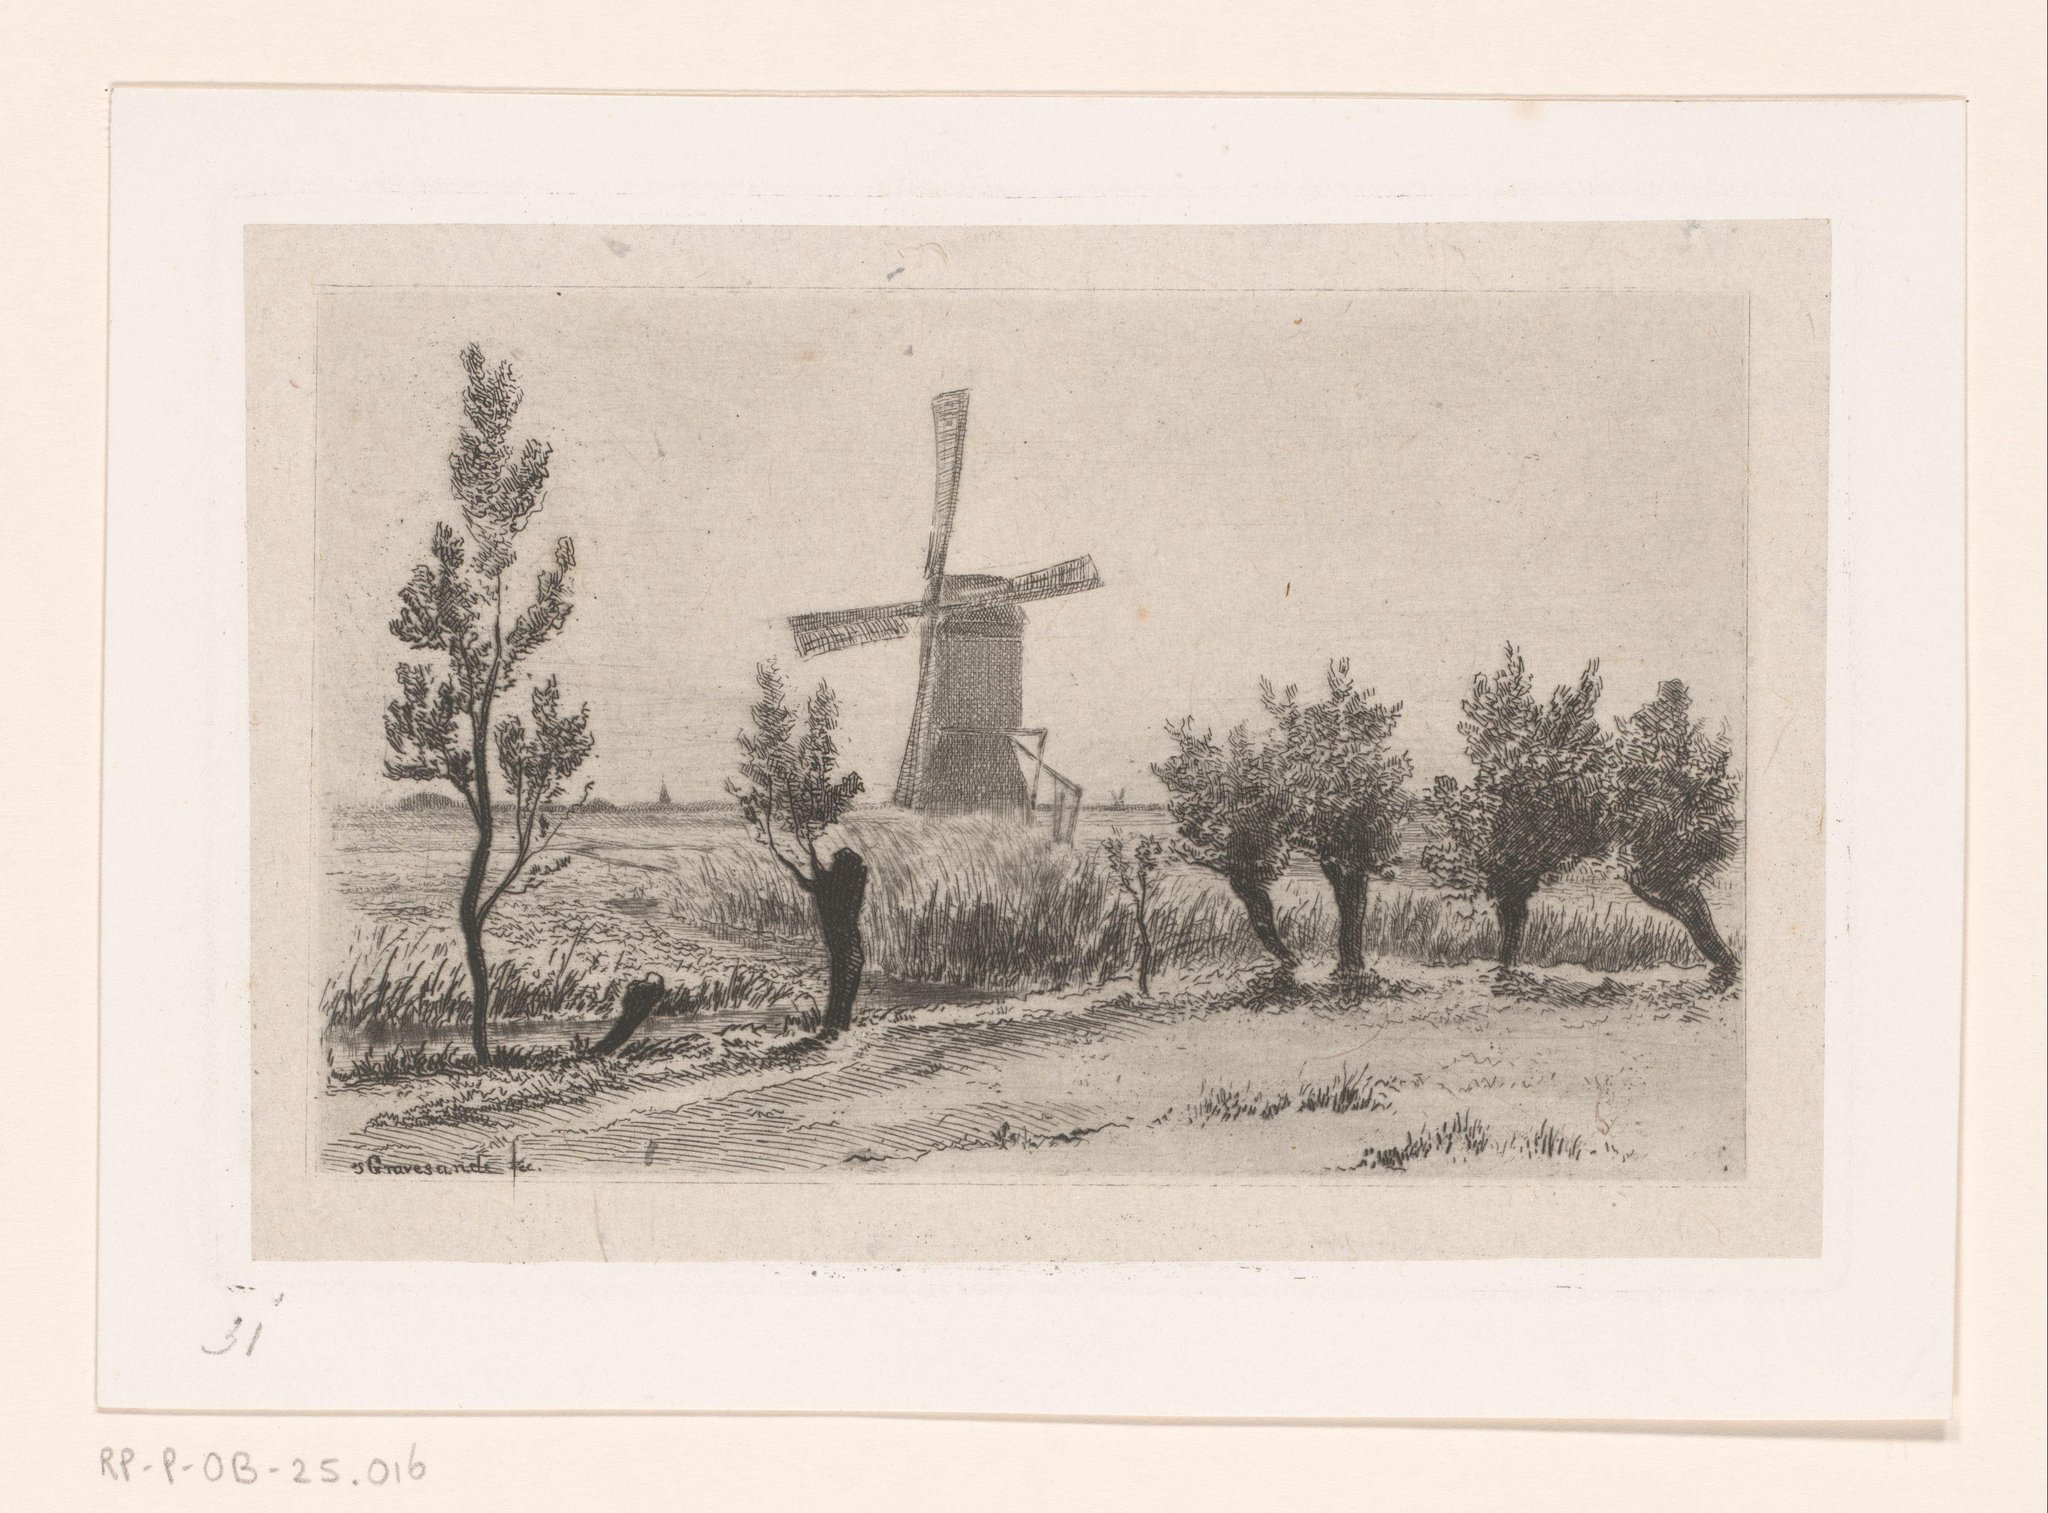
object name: print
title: Moulin près d'Abconde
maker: carel nicolaas storm van s-gravesande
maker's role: draughtsman, print maker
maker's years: 1841-1924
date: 1872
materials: paper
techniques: etching, intaglio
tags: windmill in landscape, trees: willow, abcoude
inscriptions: collector's mark: Lugt 2228